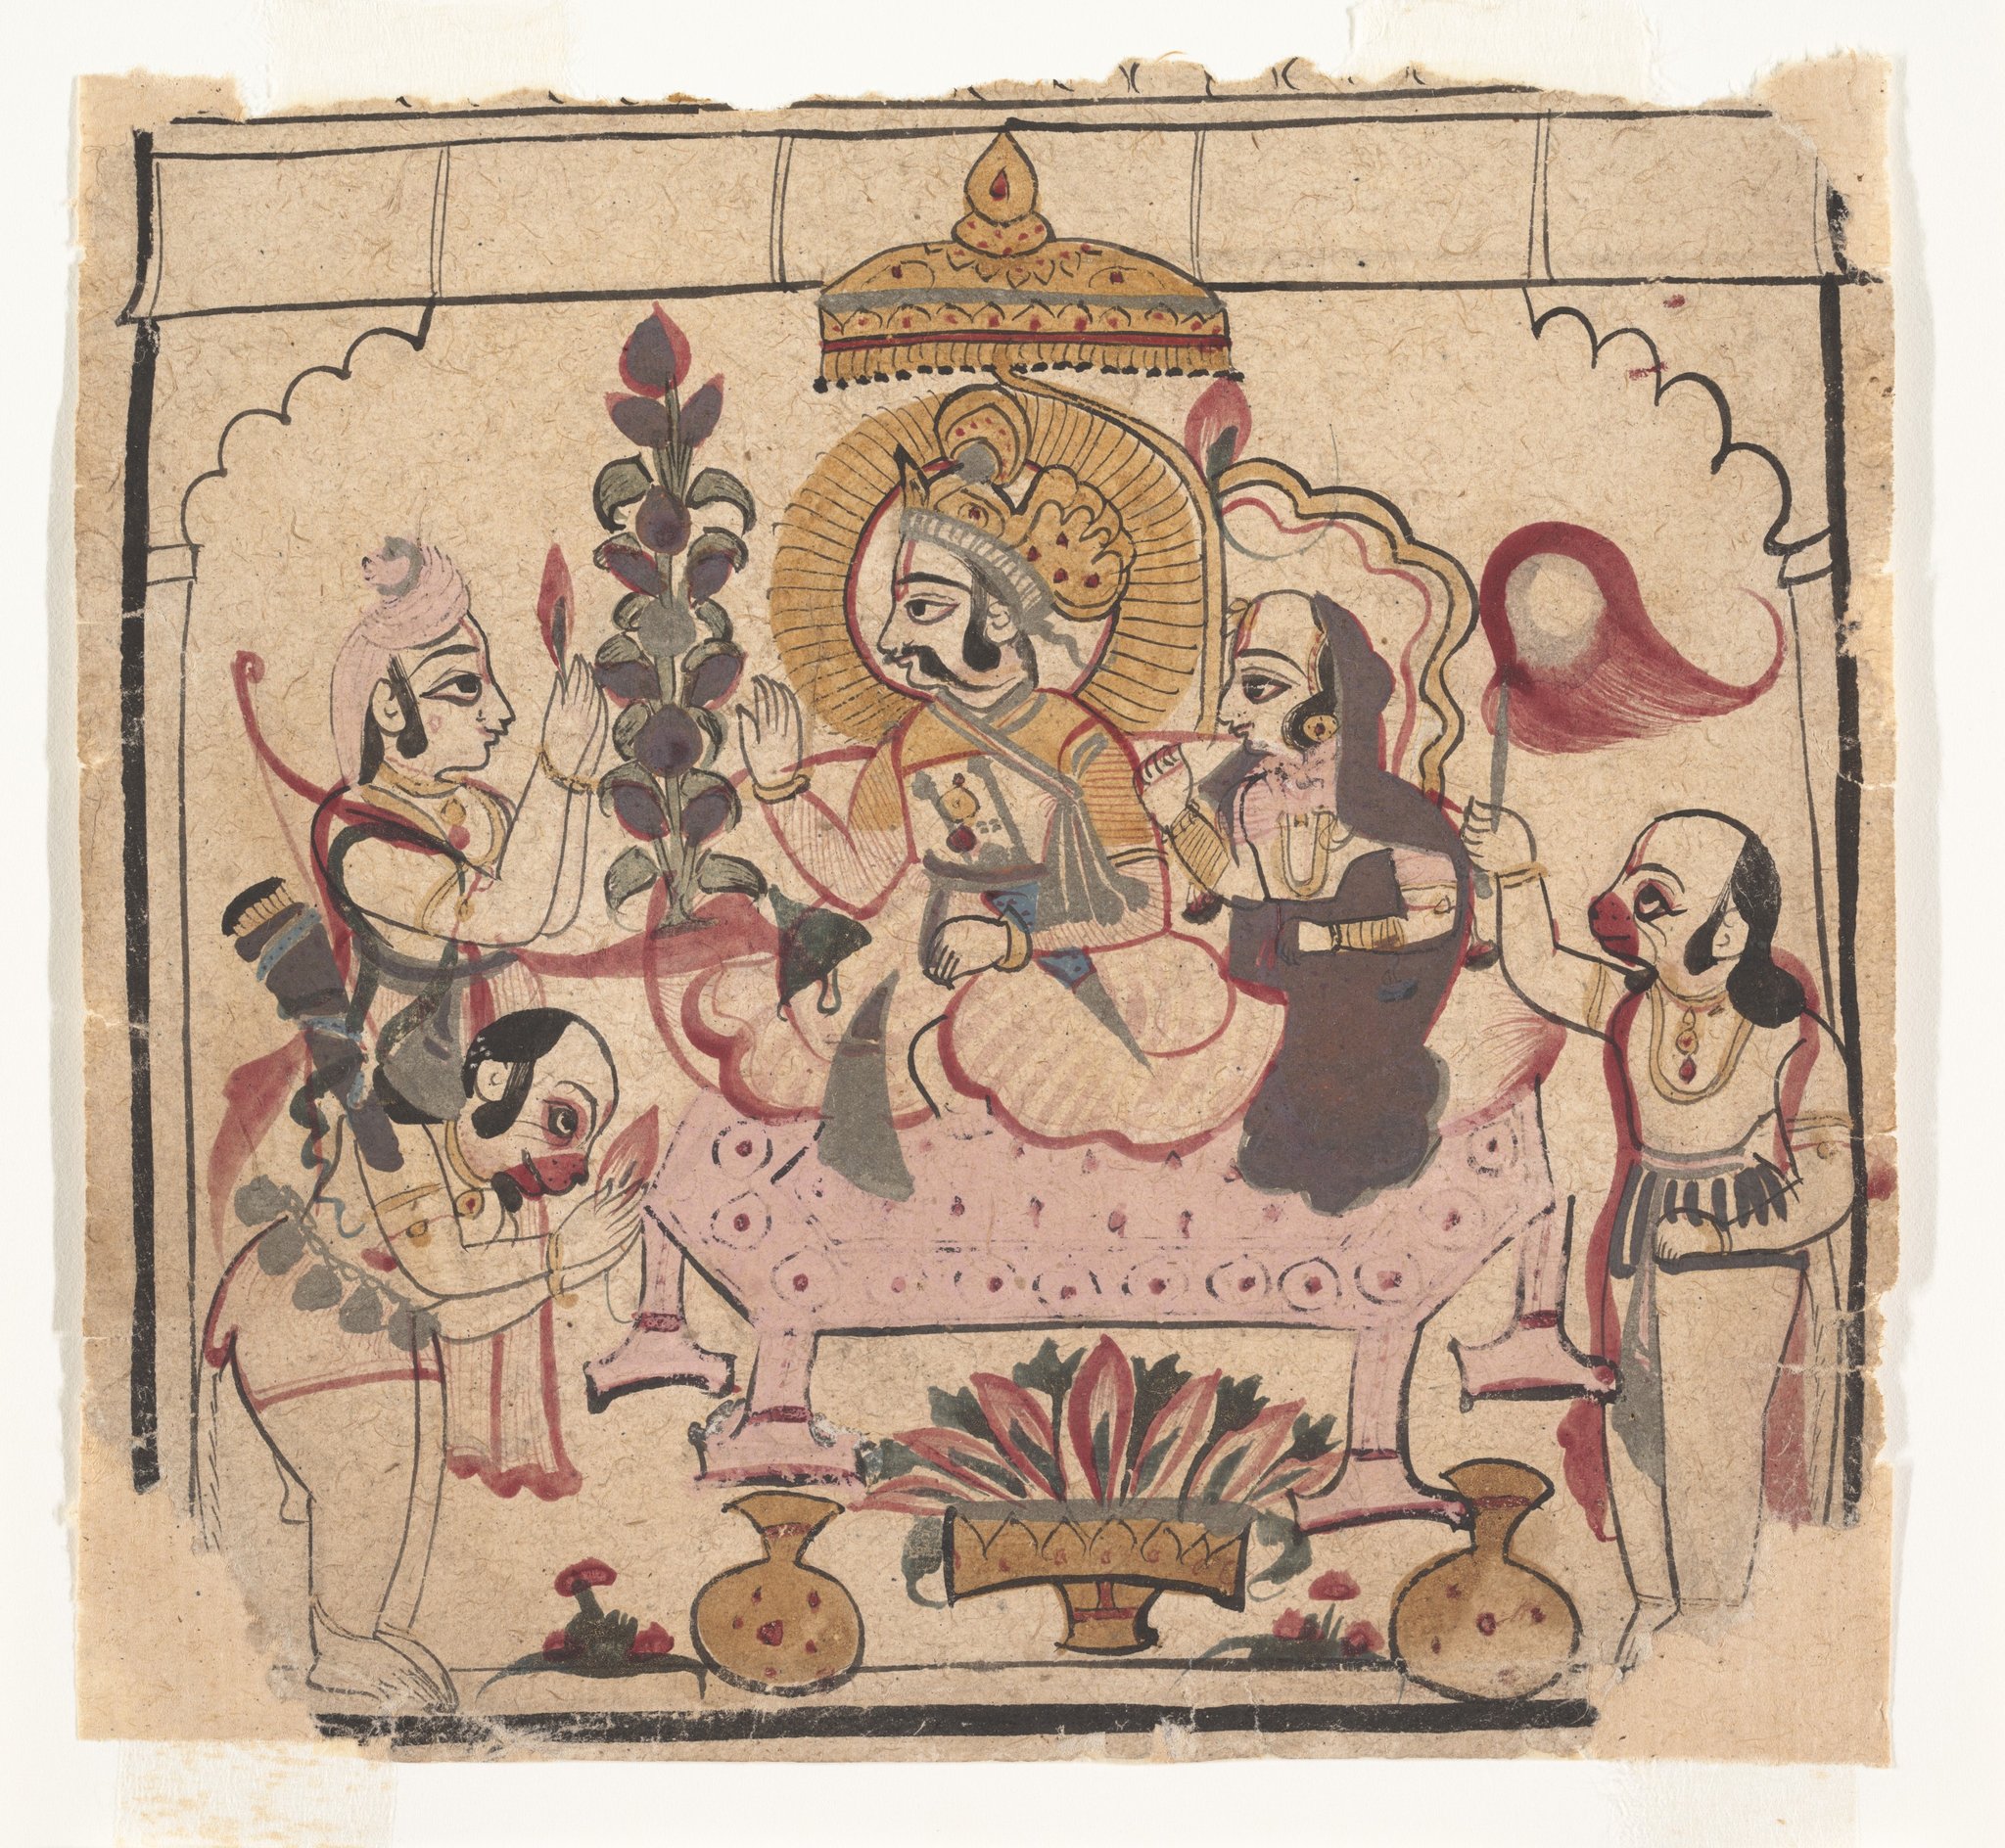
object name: folio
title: Page from a Dispersed Ramayana: (Story of Rama)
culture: indian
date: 1734-1766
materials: ink, paper, watercolor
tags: kings,men,women